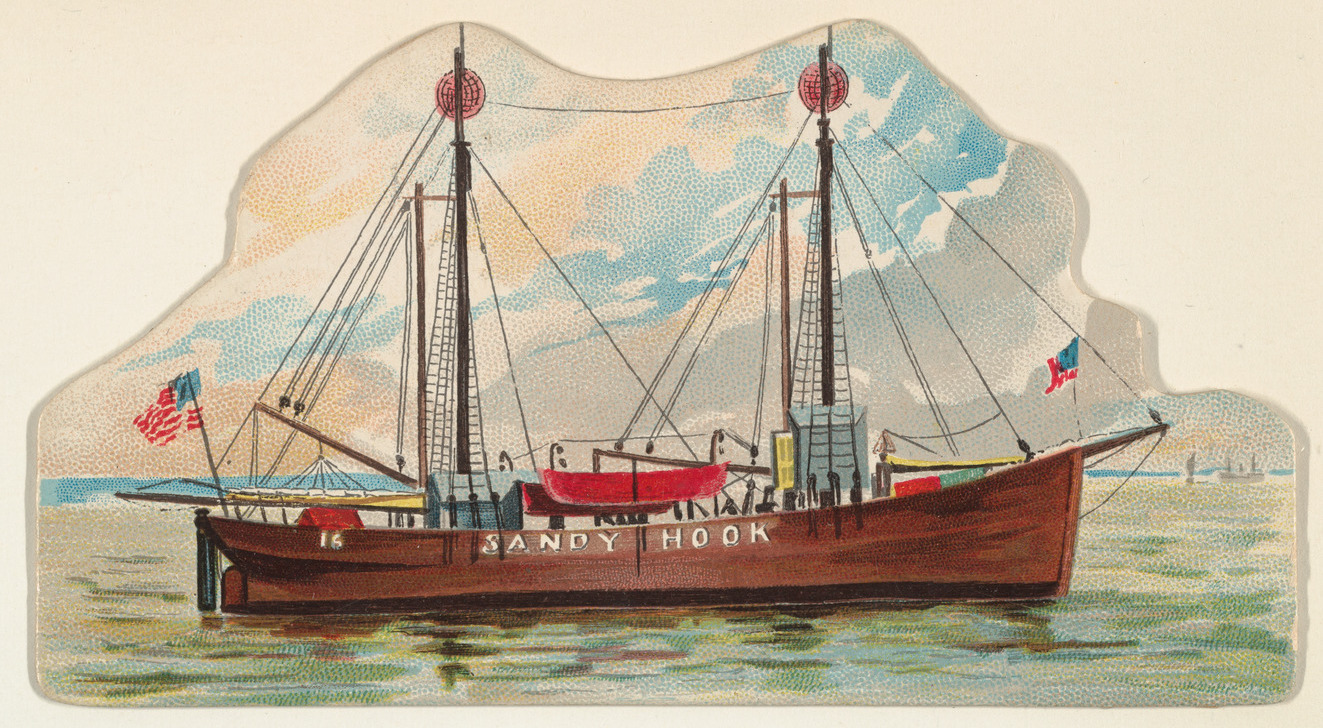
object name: print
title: Sandy Hook, from the Lighthouses series (N119) issued by Duke Sons & Co. to promote Honest Long Cut Tobacco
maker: w. duke, sons & co.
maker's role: publisher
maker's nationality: american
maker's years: 1870-1920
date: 1889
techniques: color lithograph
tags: ships